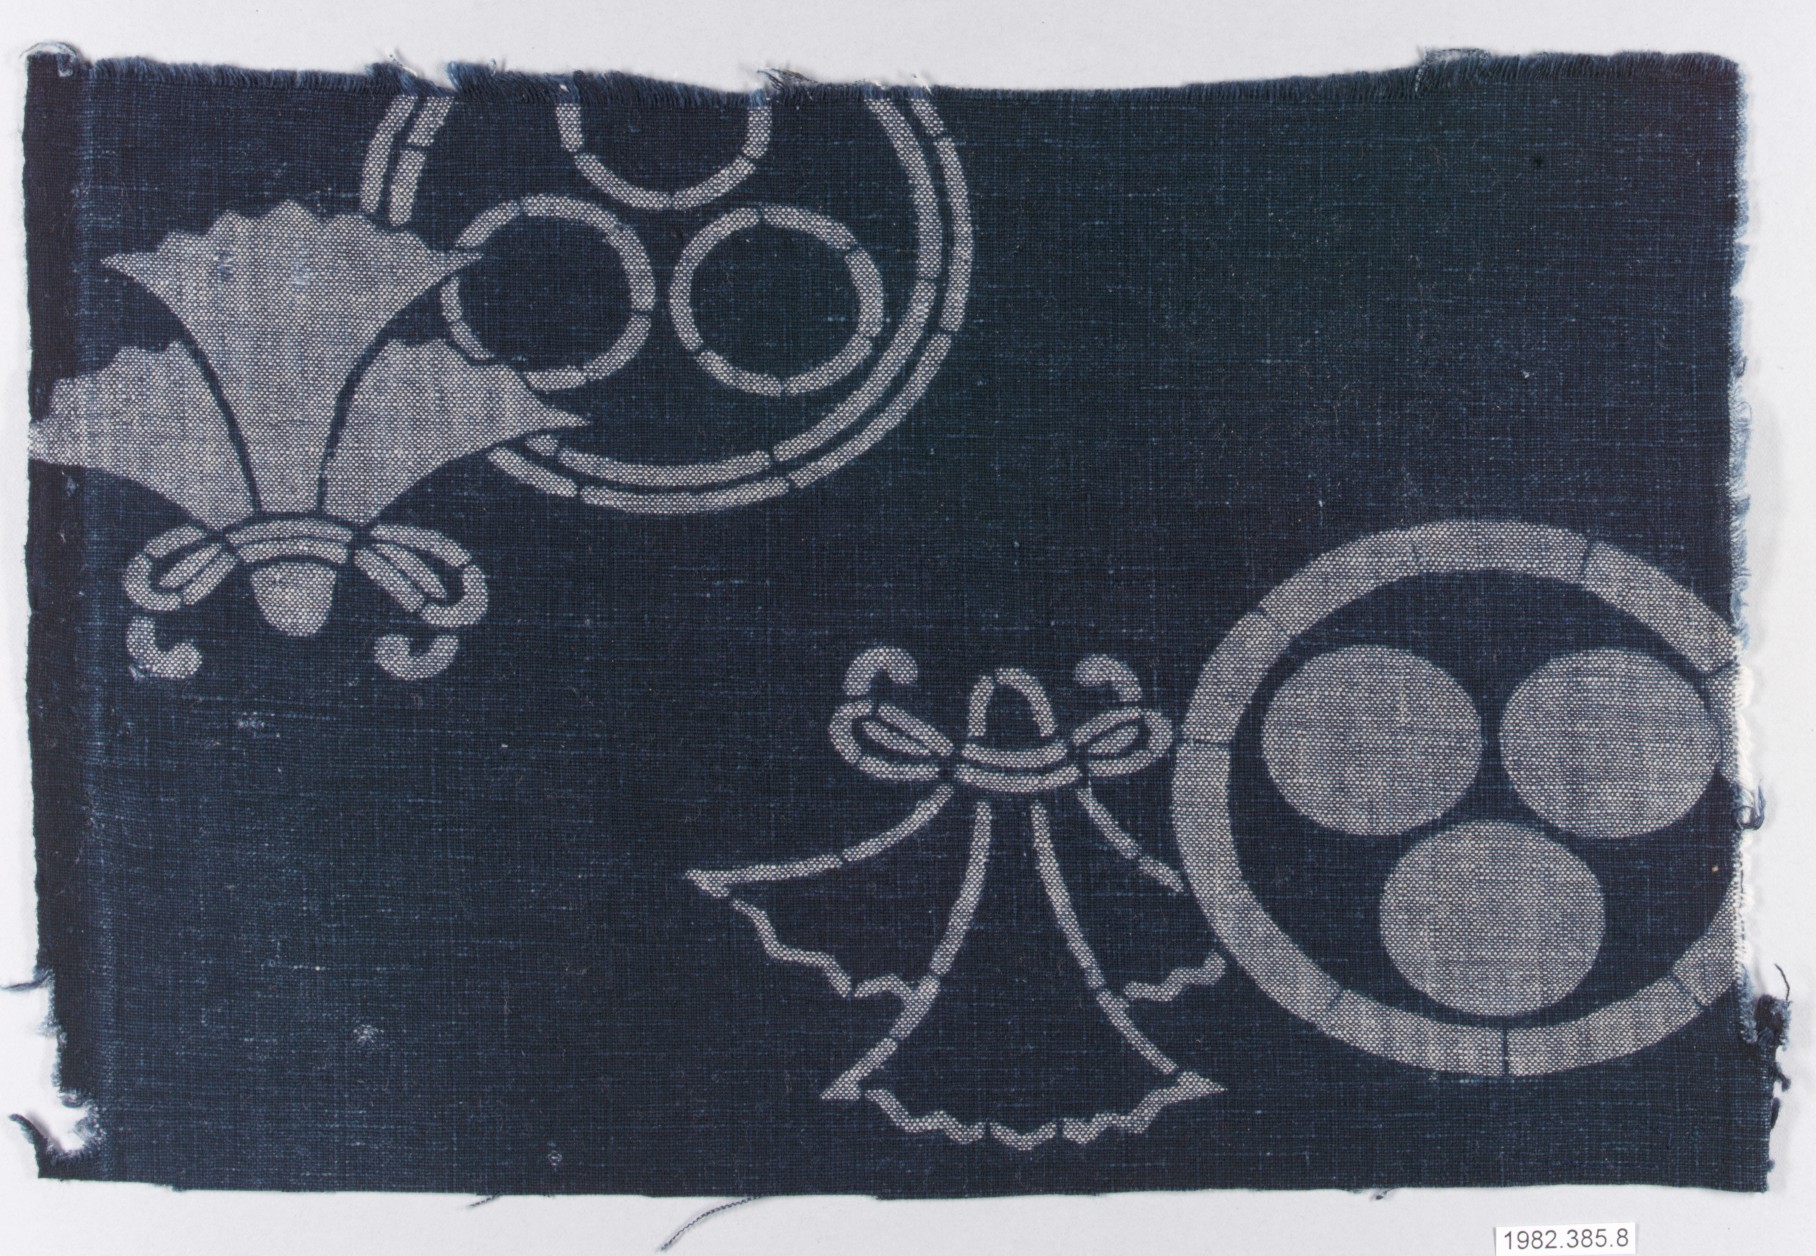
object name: piece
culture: japanese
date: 1868-1926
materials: cotton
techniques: dyeing